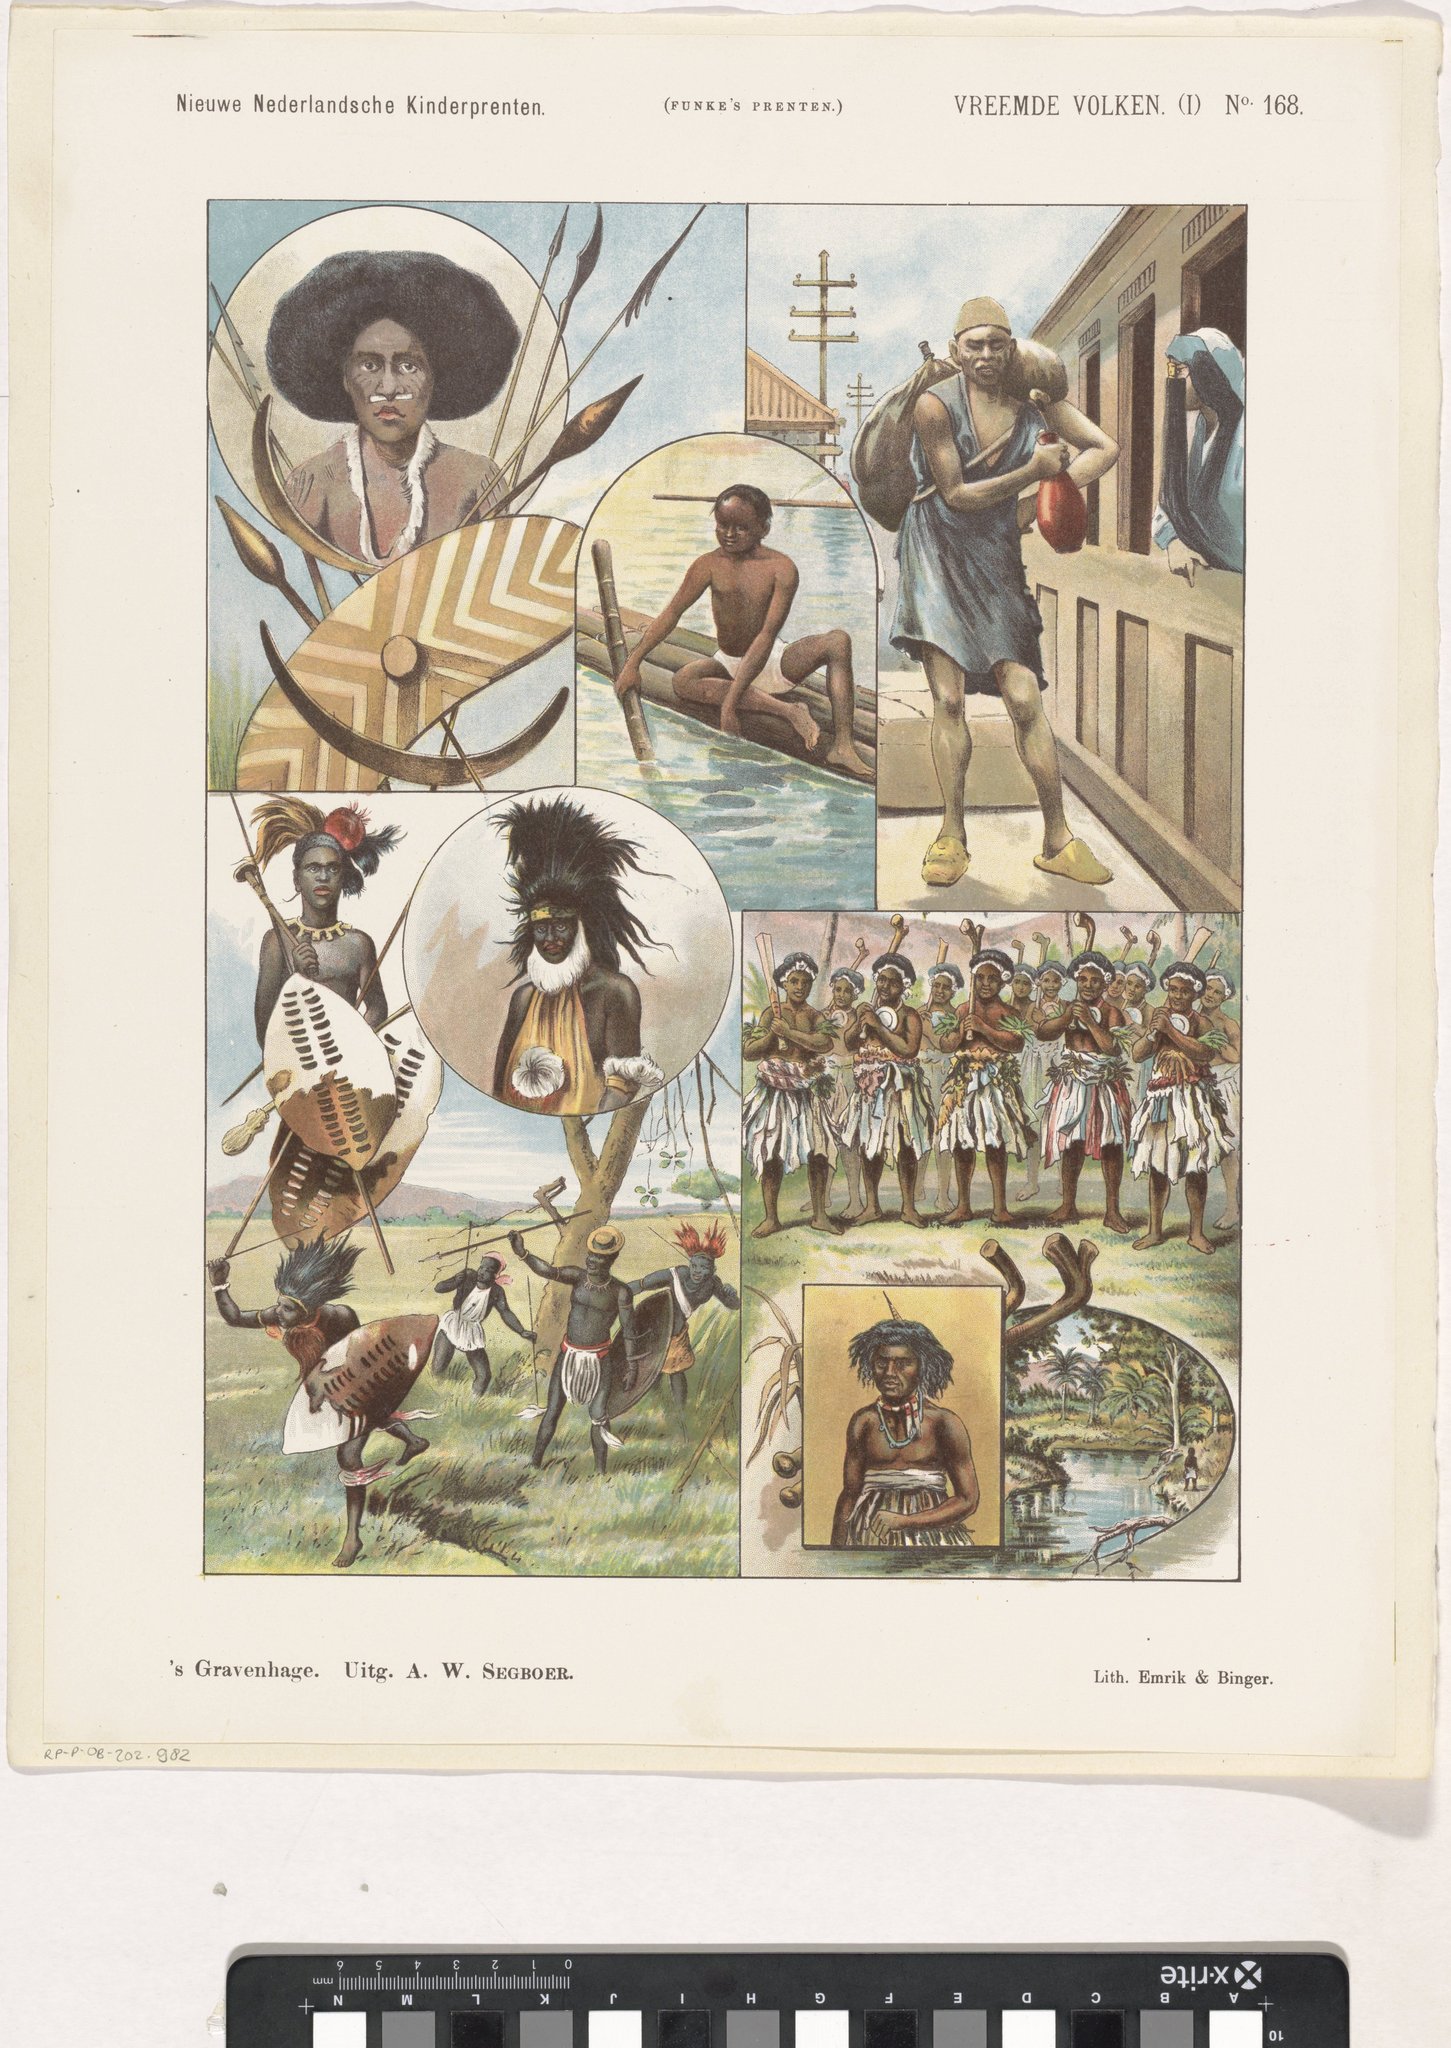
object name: popular print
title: Funke's prenten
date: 1903-1919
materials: paper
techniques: lithograph, letterpress printing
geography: haarlem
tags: human races; peoples; nationalities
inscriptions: collector's mark: Lugt 2760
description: Blad met 7 voorstellingen van vreemde volken. Genummerd rechtsboven: No. 168.